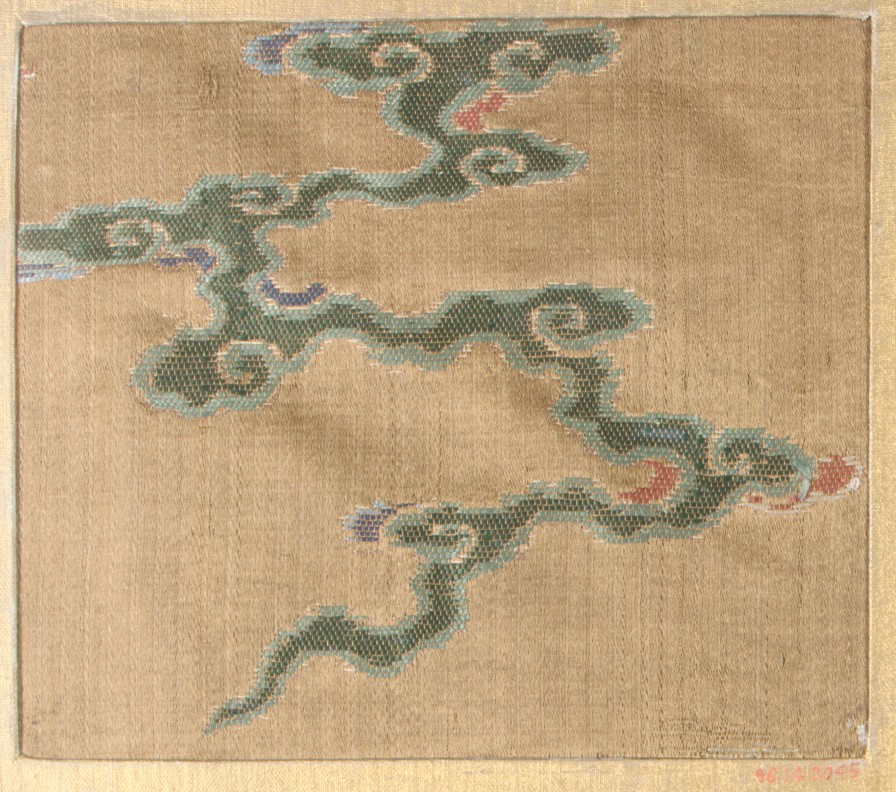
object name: piece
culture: chinese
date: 1701-1900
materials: silk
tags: clouds